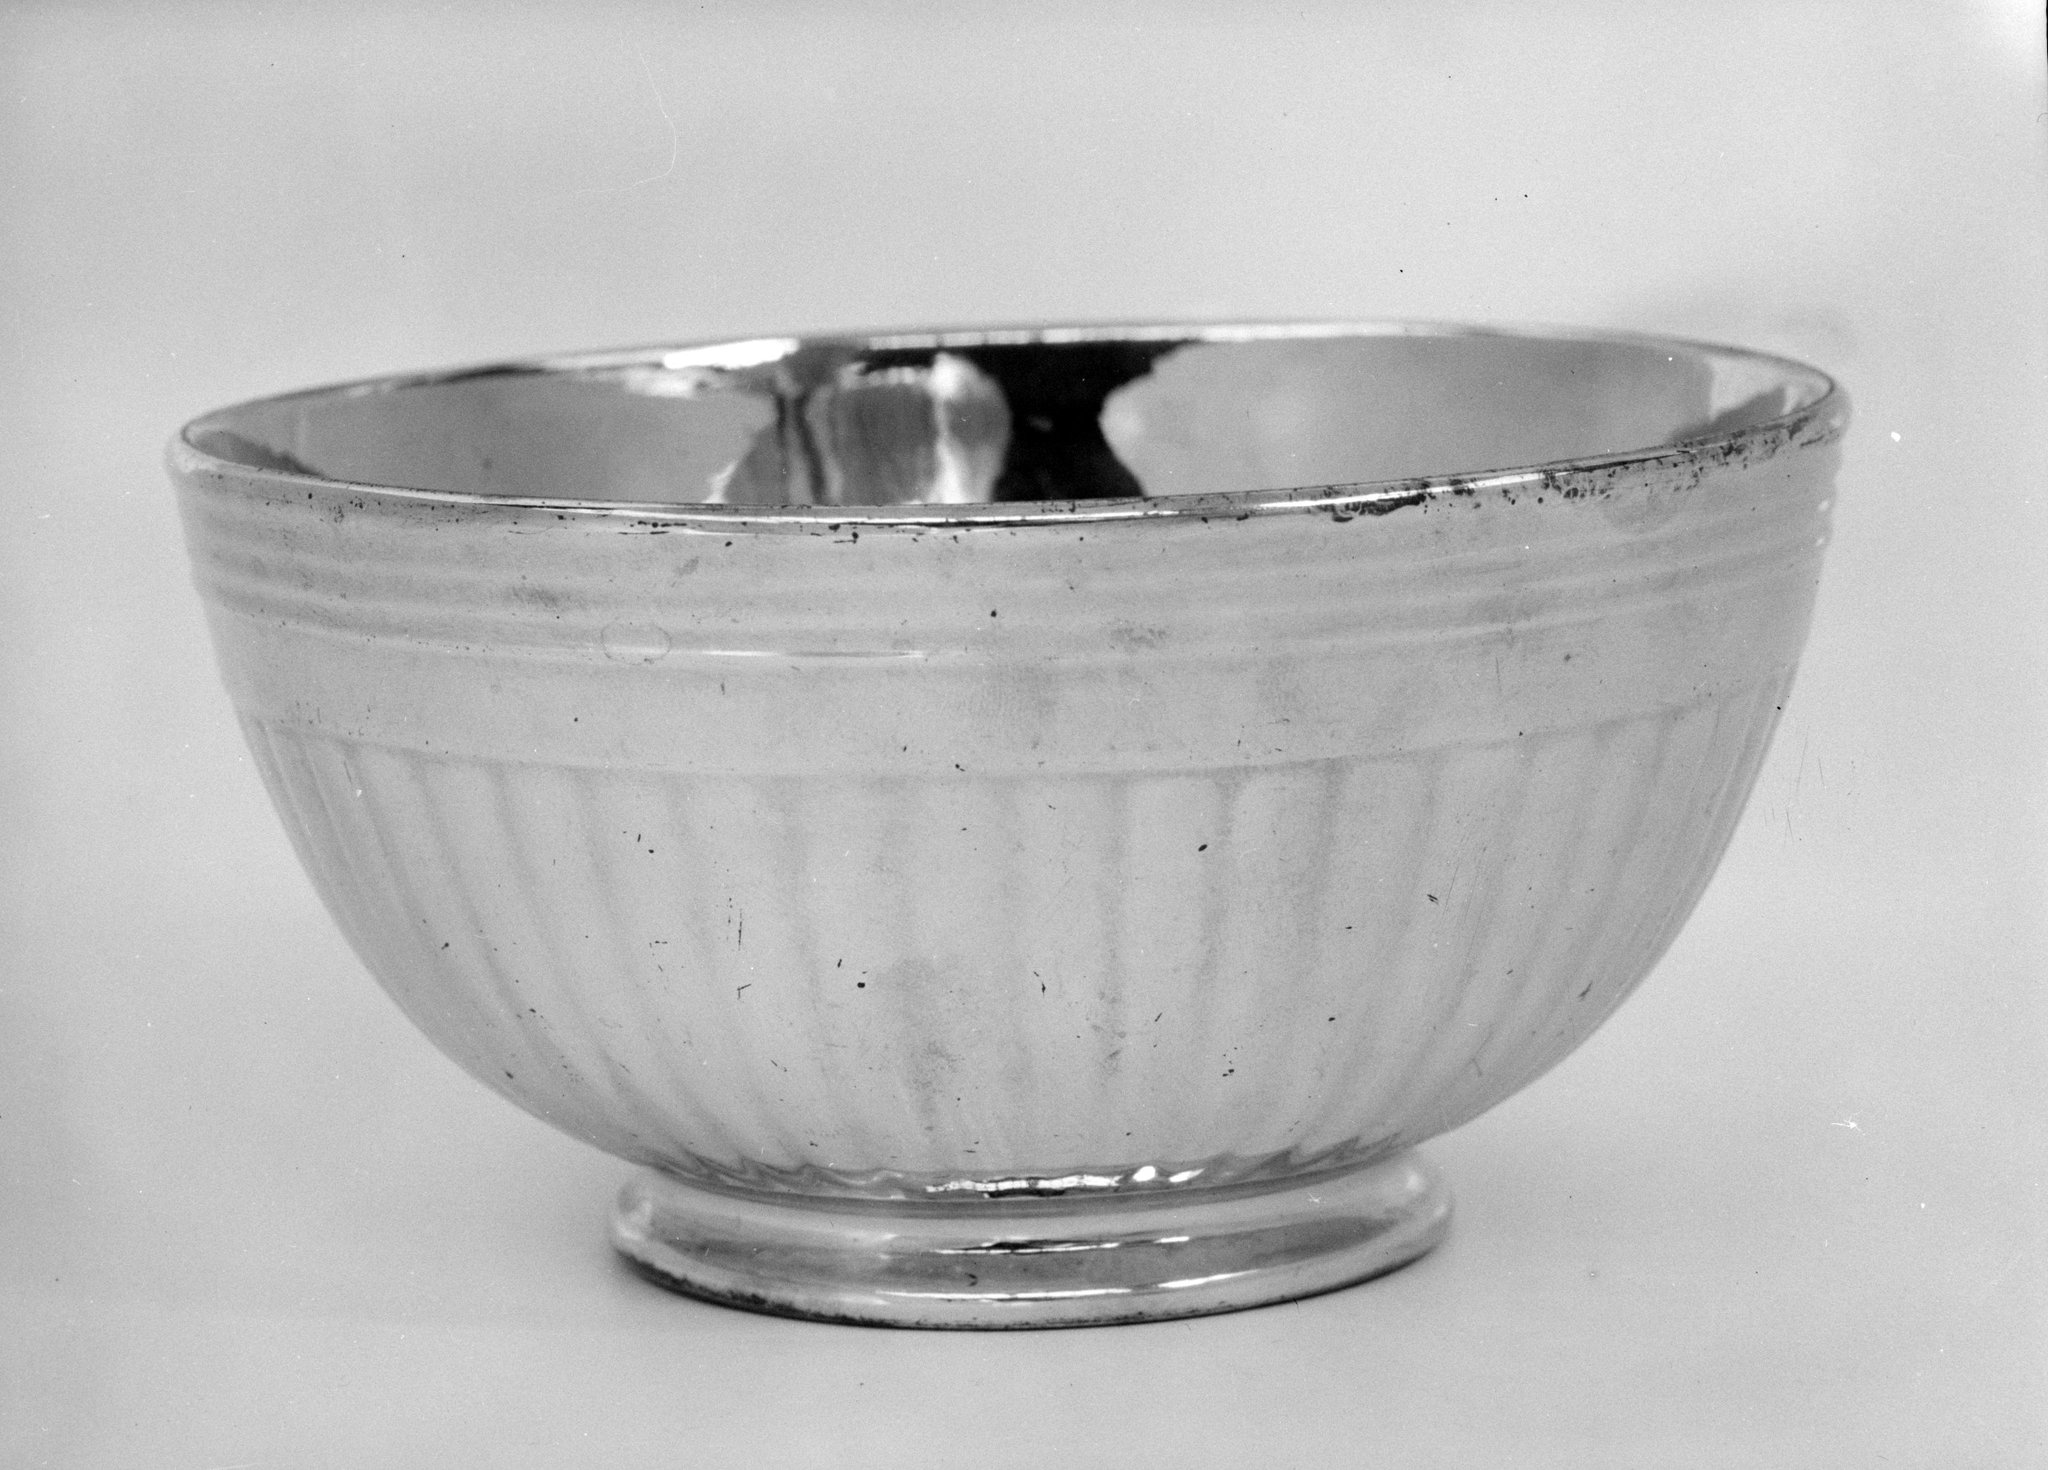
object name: bowl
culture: british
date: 1800-1830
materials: earthenware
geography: england